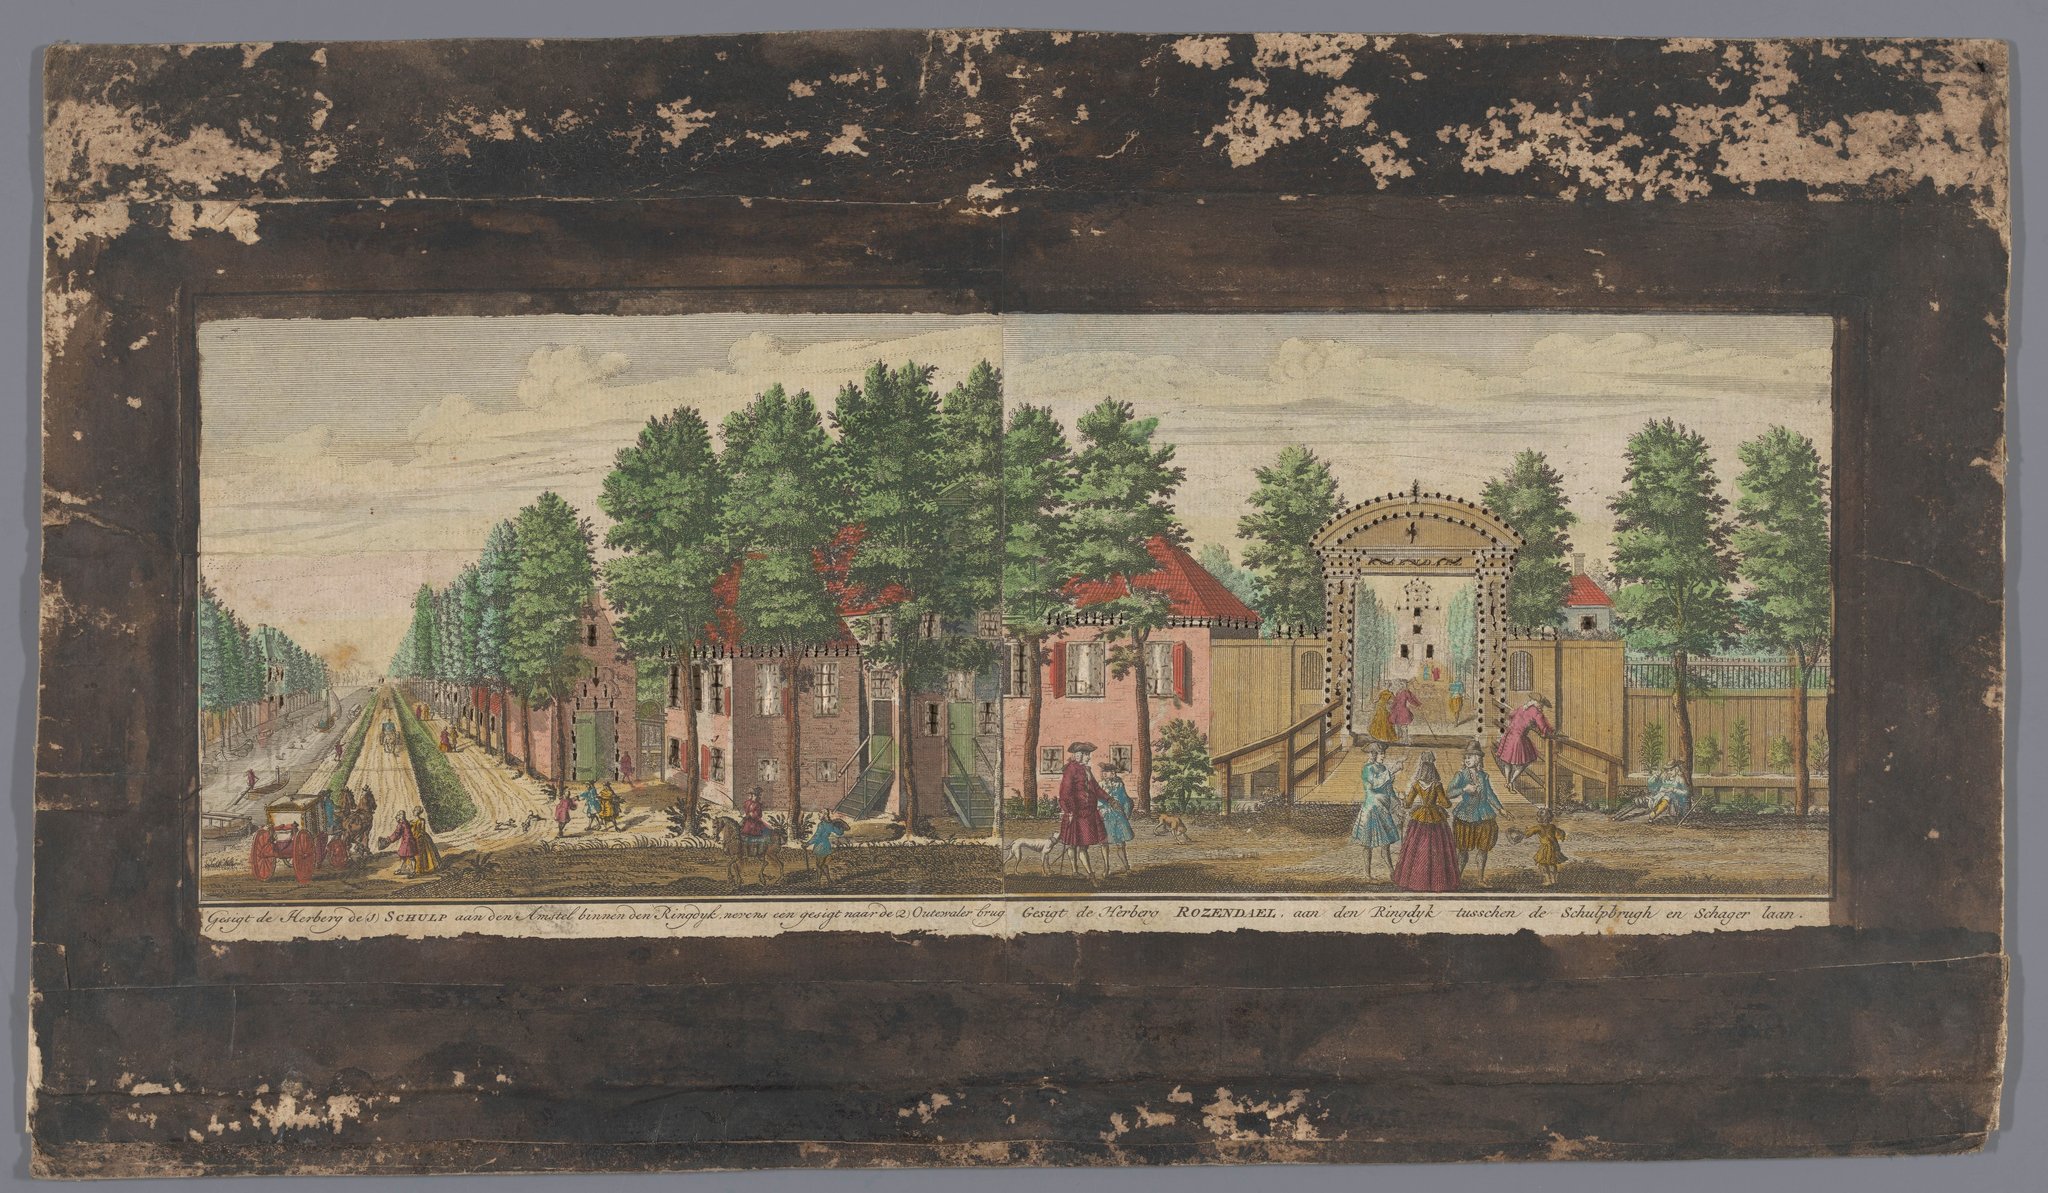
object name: print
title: Gezicht op de herberg De Schulp en de herberg Rozendael aan de Ringdijk te Amsterdam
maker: Anonymous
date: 1700-1799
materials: cardboard, paint, paper, watercolor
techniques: brush, cutting, etching, perforating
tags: bridge in city across river, canal, etc. (+ city(-scape) with figures, staffage), dikes, levee, hotel, hostelry, inn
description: Links de Oetewalerbrug over de Ringvaart.